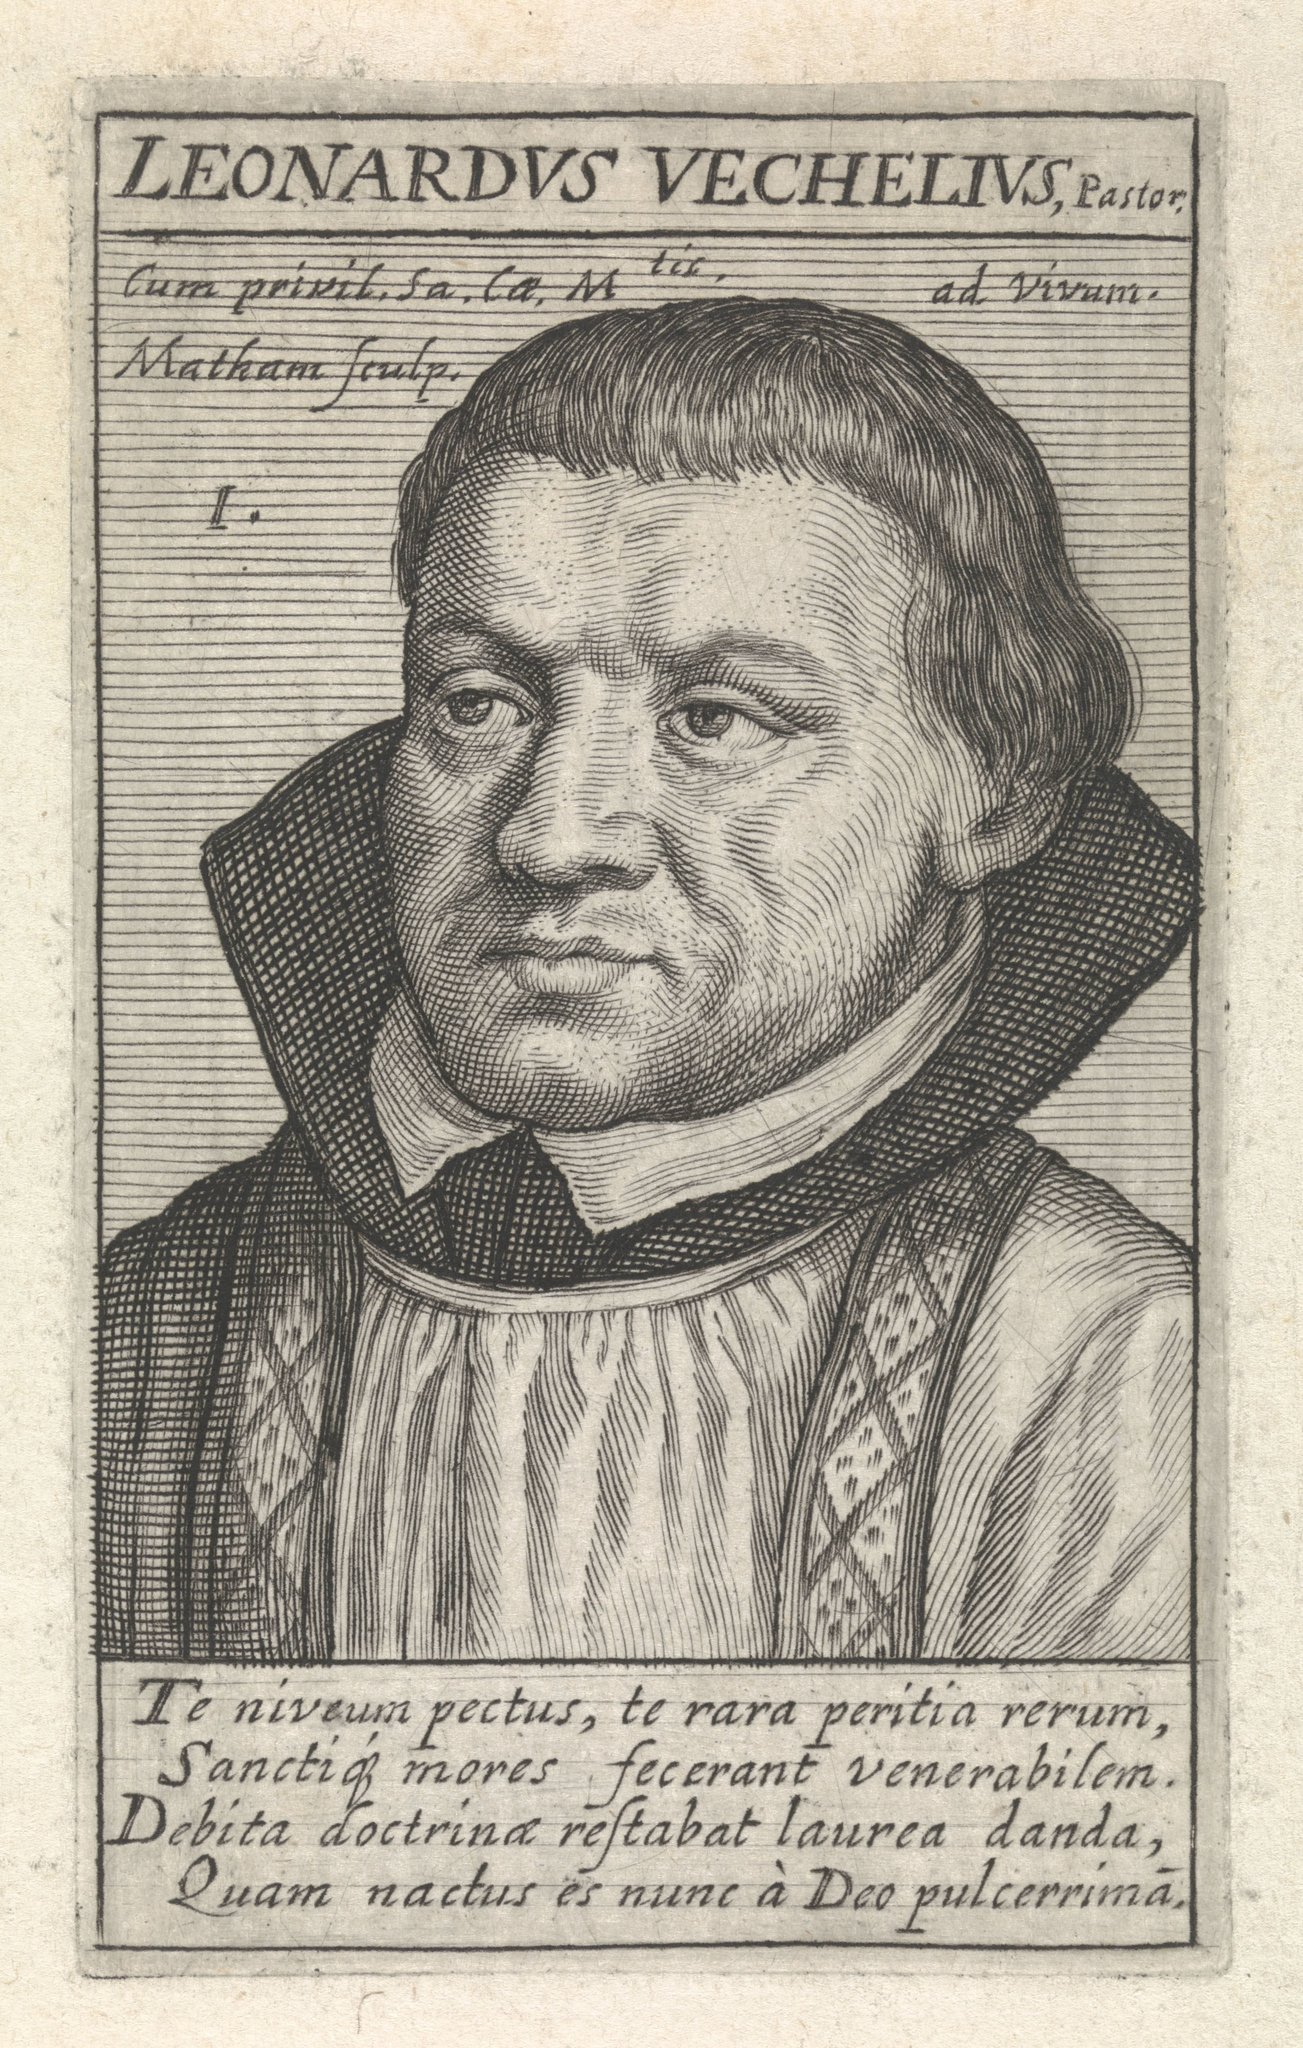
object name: print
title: Portret van H. Leonard Vechel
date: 1617-1618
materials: paper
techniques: engraving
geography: haarlem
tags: den bosch, brielle, martyrs of gorkum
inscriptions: collector's mark: Lugt 2228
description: Portret van de heilige Leonard Vechel, een van de negentien katholieke martelaren van Gorinchem.